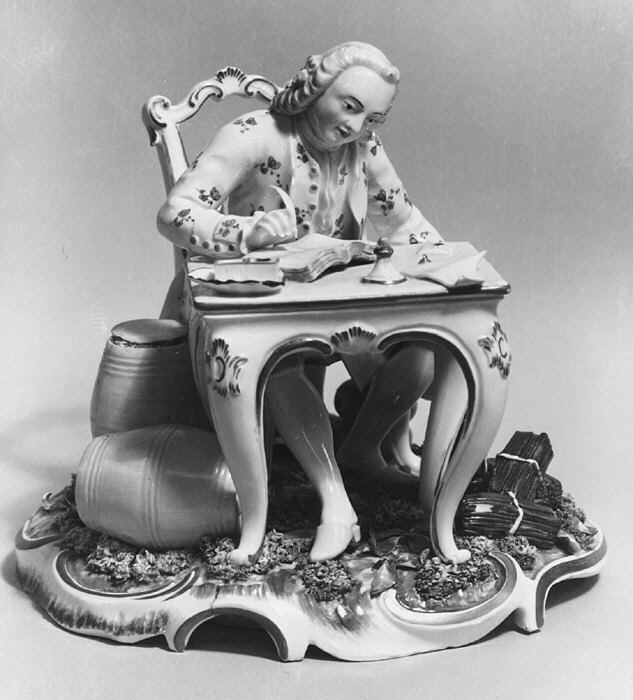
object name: figure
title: Merchant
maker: frankenthal porcelain manufactory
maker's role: manufactory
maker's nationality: german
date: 1765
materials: hard paste porcelain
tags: men,writing,desks